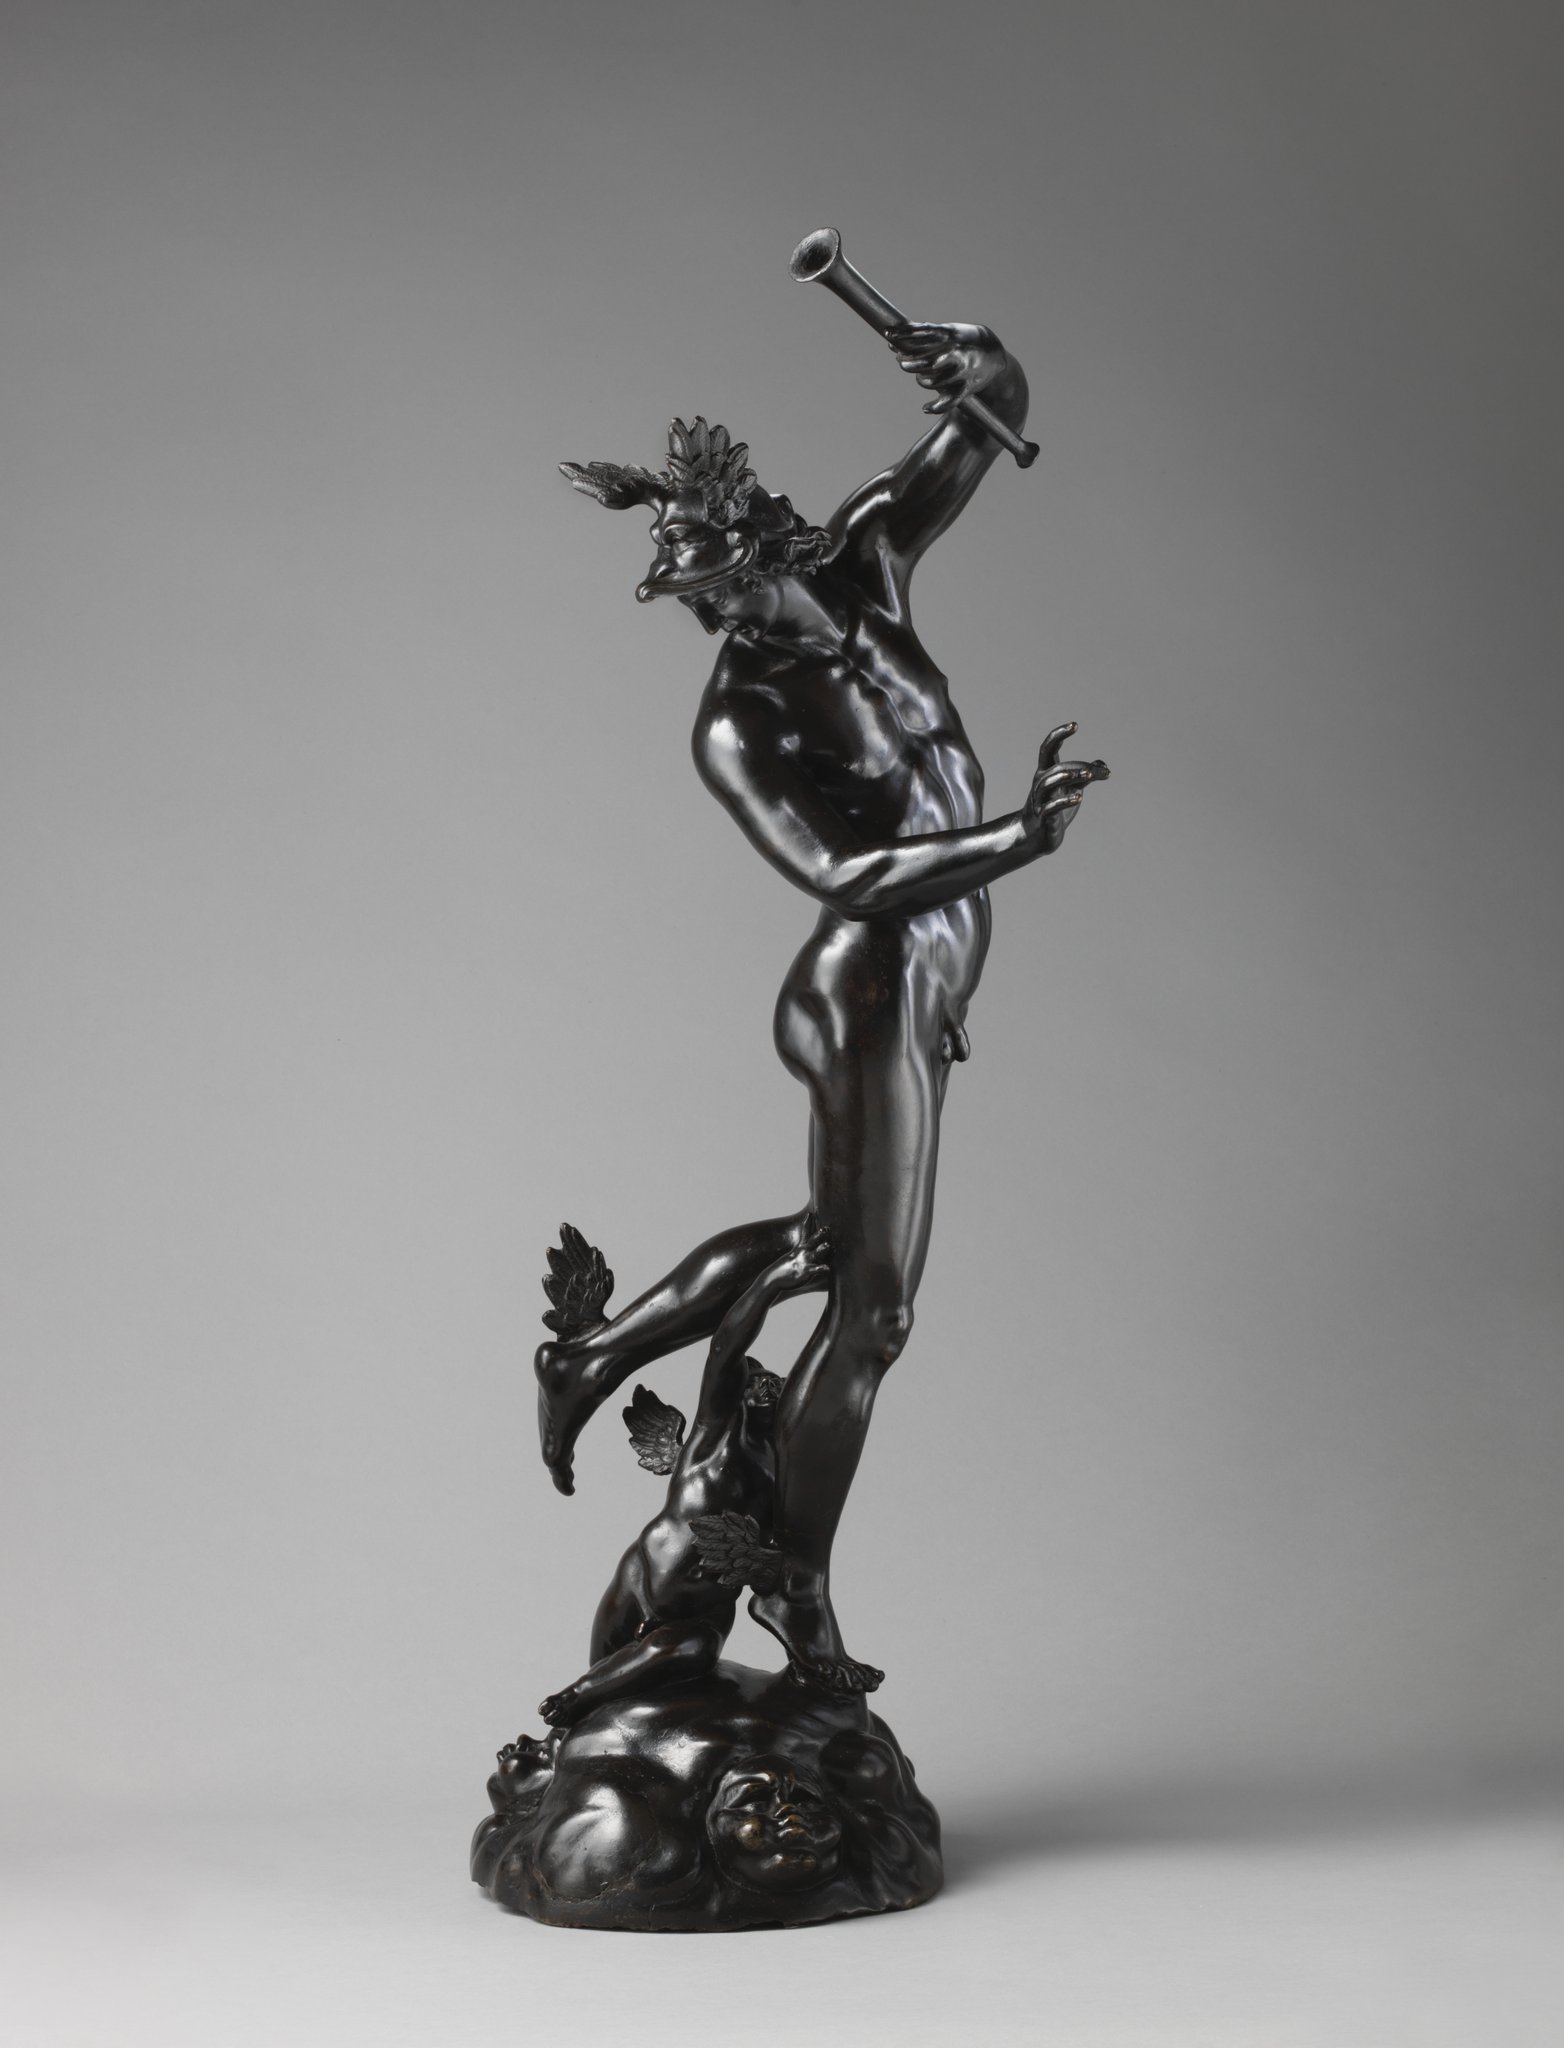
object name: statuette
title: Mercury and Cupid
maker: francesco fanelli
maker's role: artist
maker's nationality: italian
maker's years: 1608-1665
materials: bronze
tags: cupid,mercury